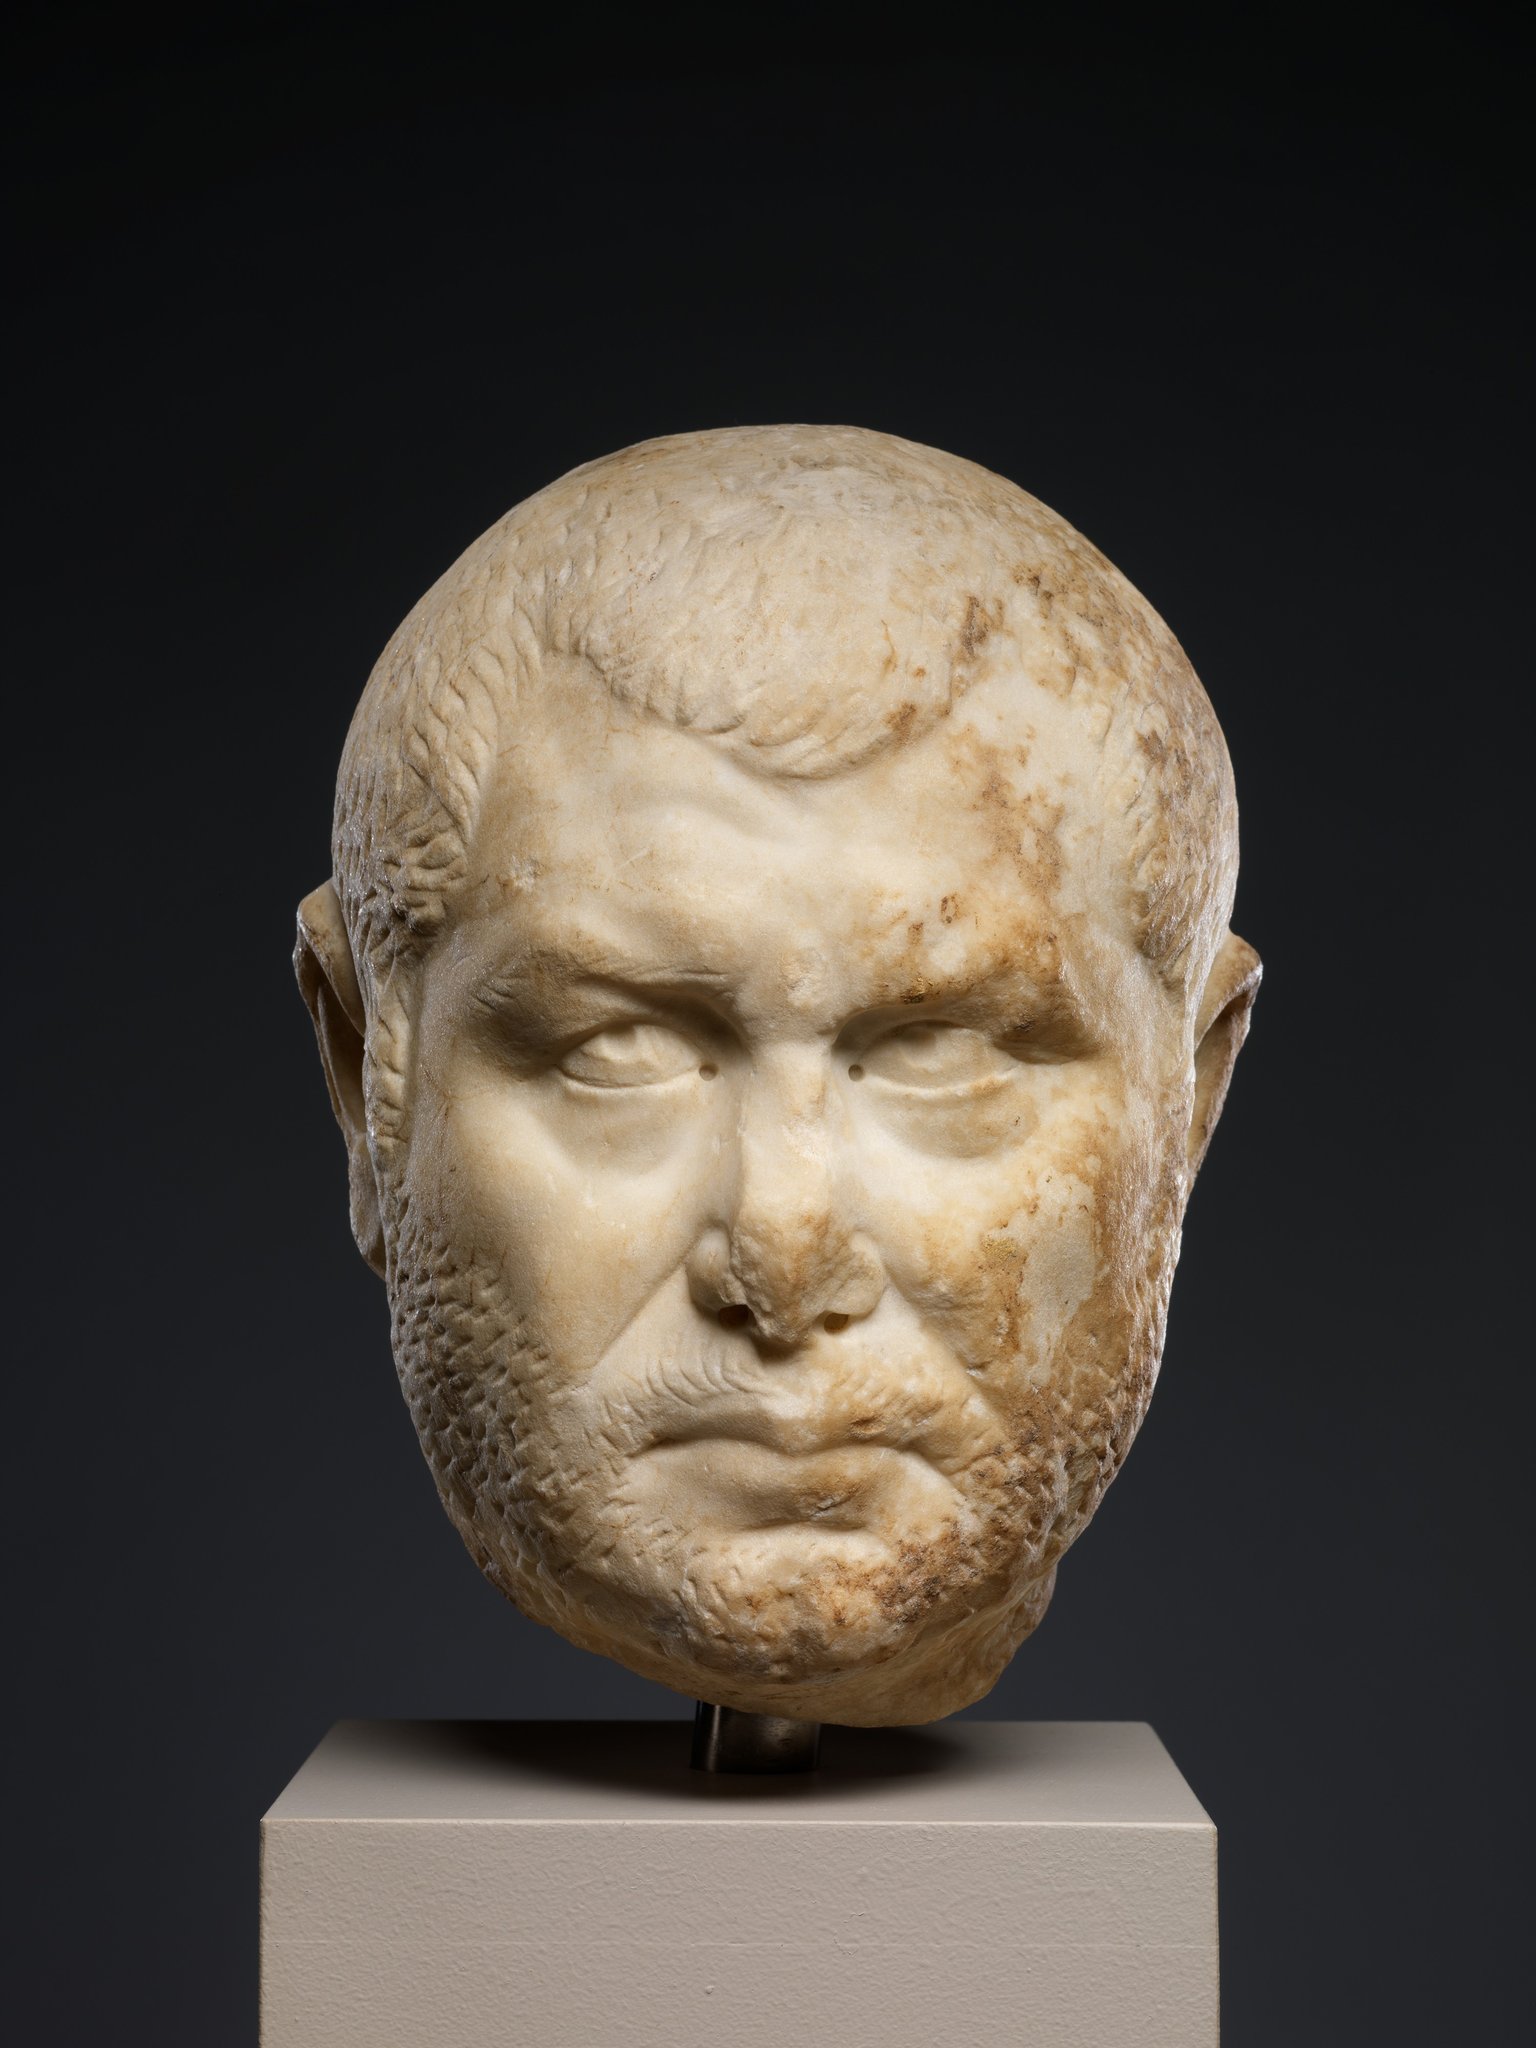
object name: portrait bust of a man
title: Marble portrait of a man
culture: roman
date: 234-266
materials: marble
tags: heads,men